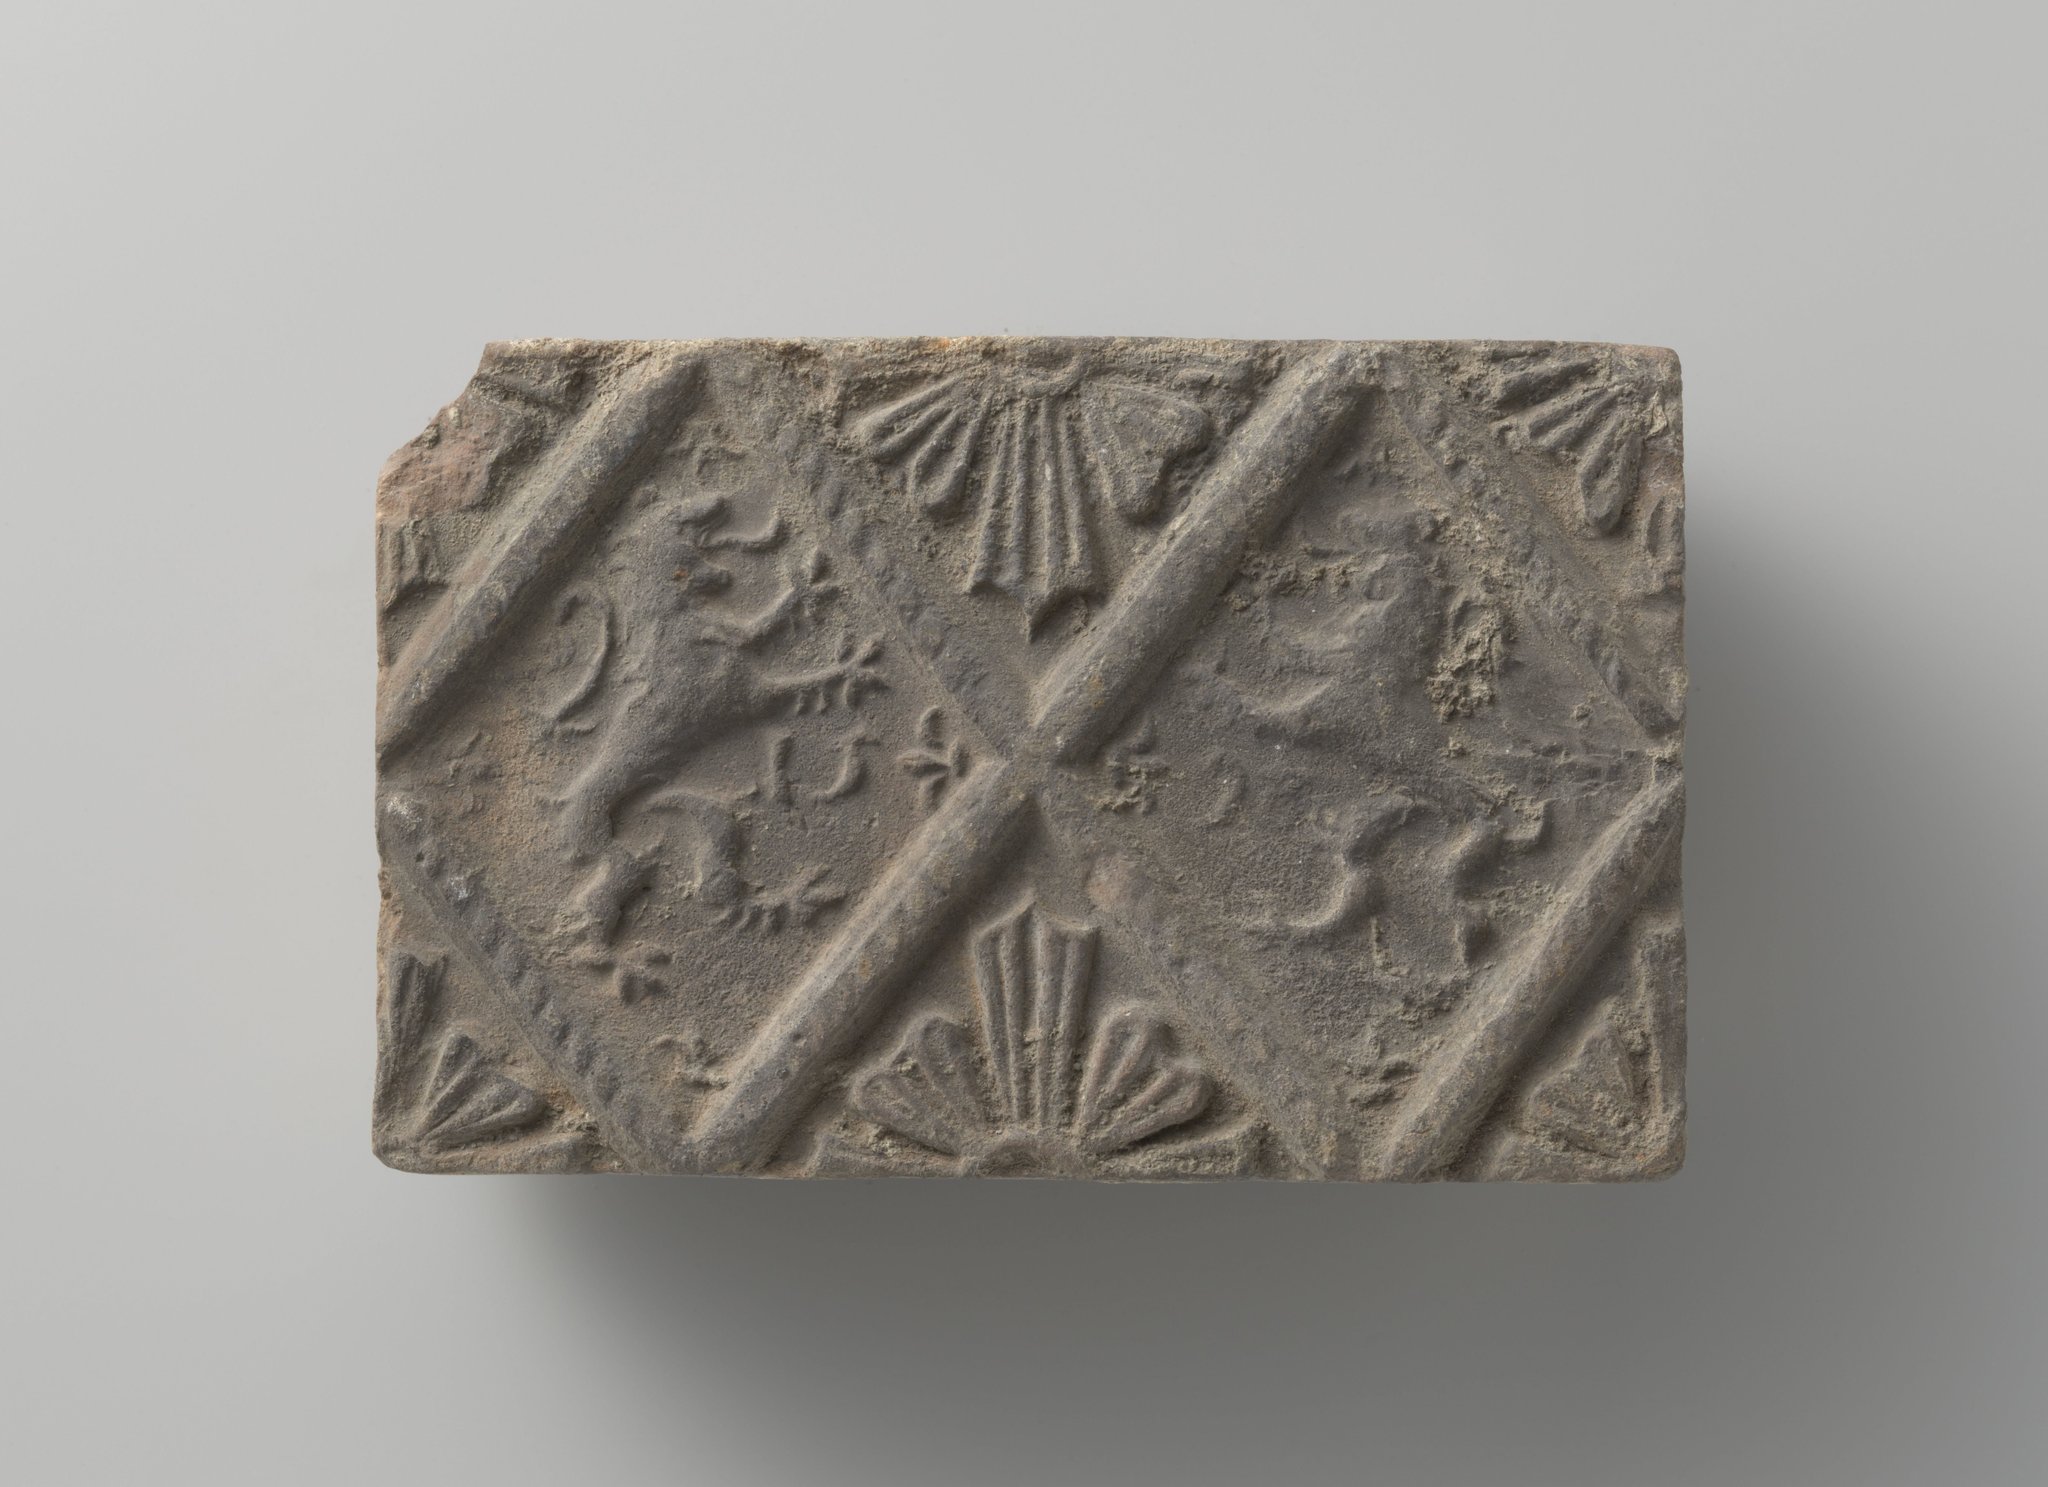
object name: hearthstone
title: Haardsteen met voorstelling van twee klimmende leeuwen, geplaatst in twee ruiten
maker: Anonymous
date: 1598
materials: earthenware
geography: southern netherlands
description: Haardsteen van gebakken aarde met ruitvormige verdeling. In elke twee ruiten: twee naar elkaar toe gekeerde klimmende leeuwen en het jaartal 1598; en in de andere een ruitvormige bloem. De leeuwen zijn van enigszins andere vorm dan BK-NM-9587.